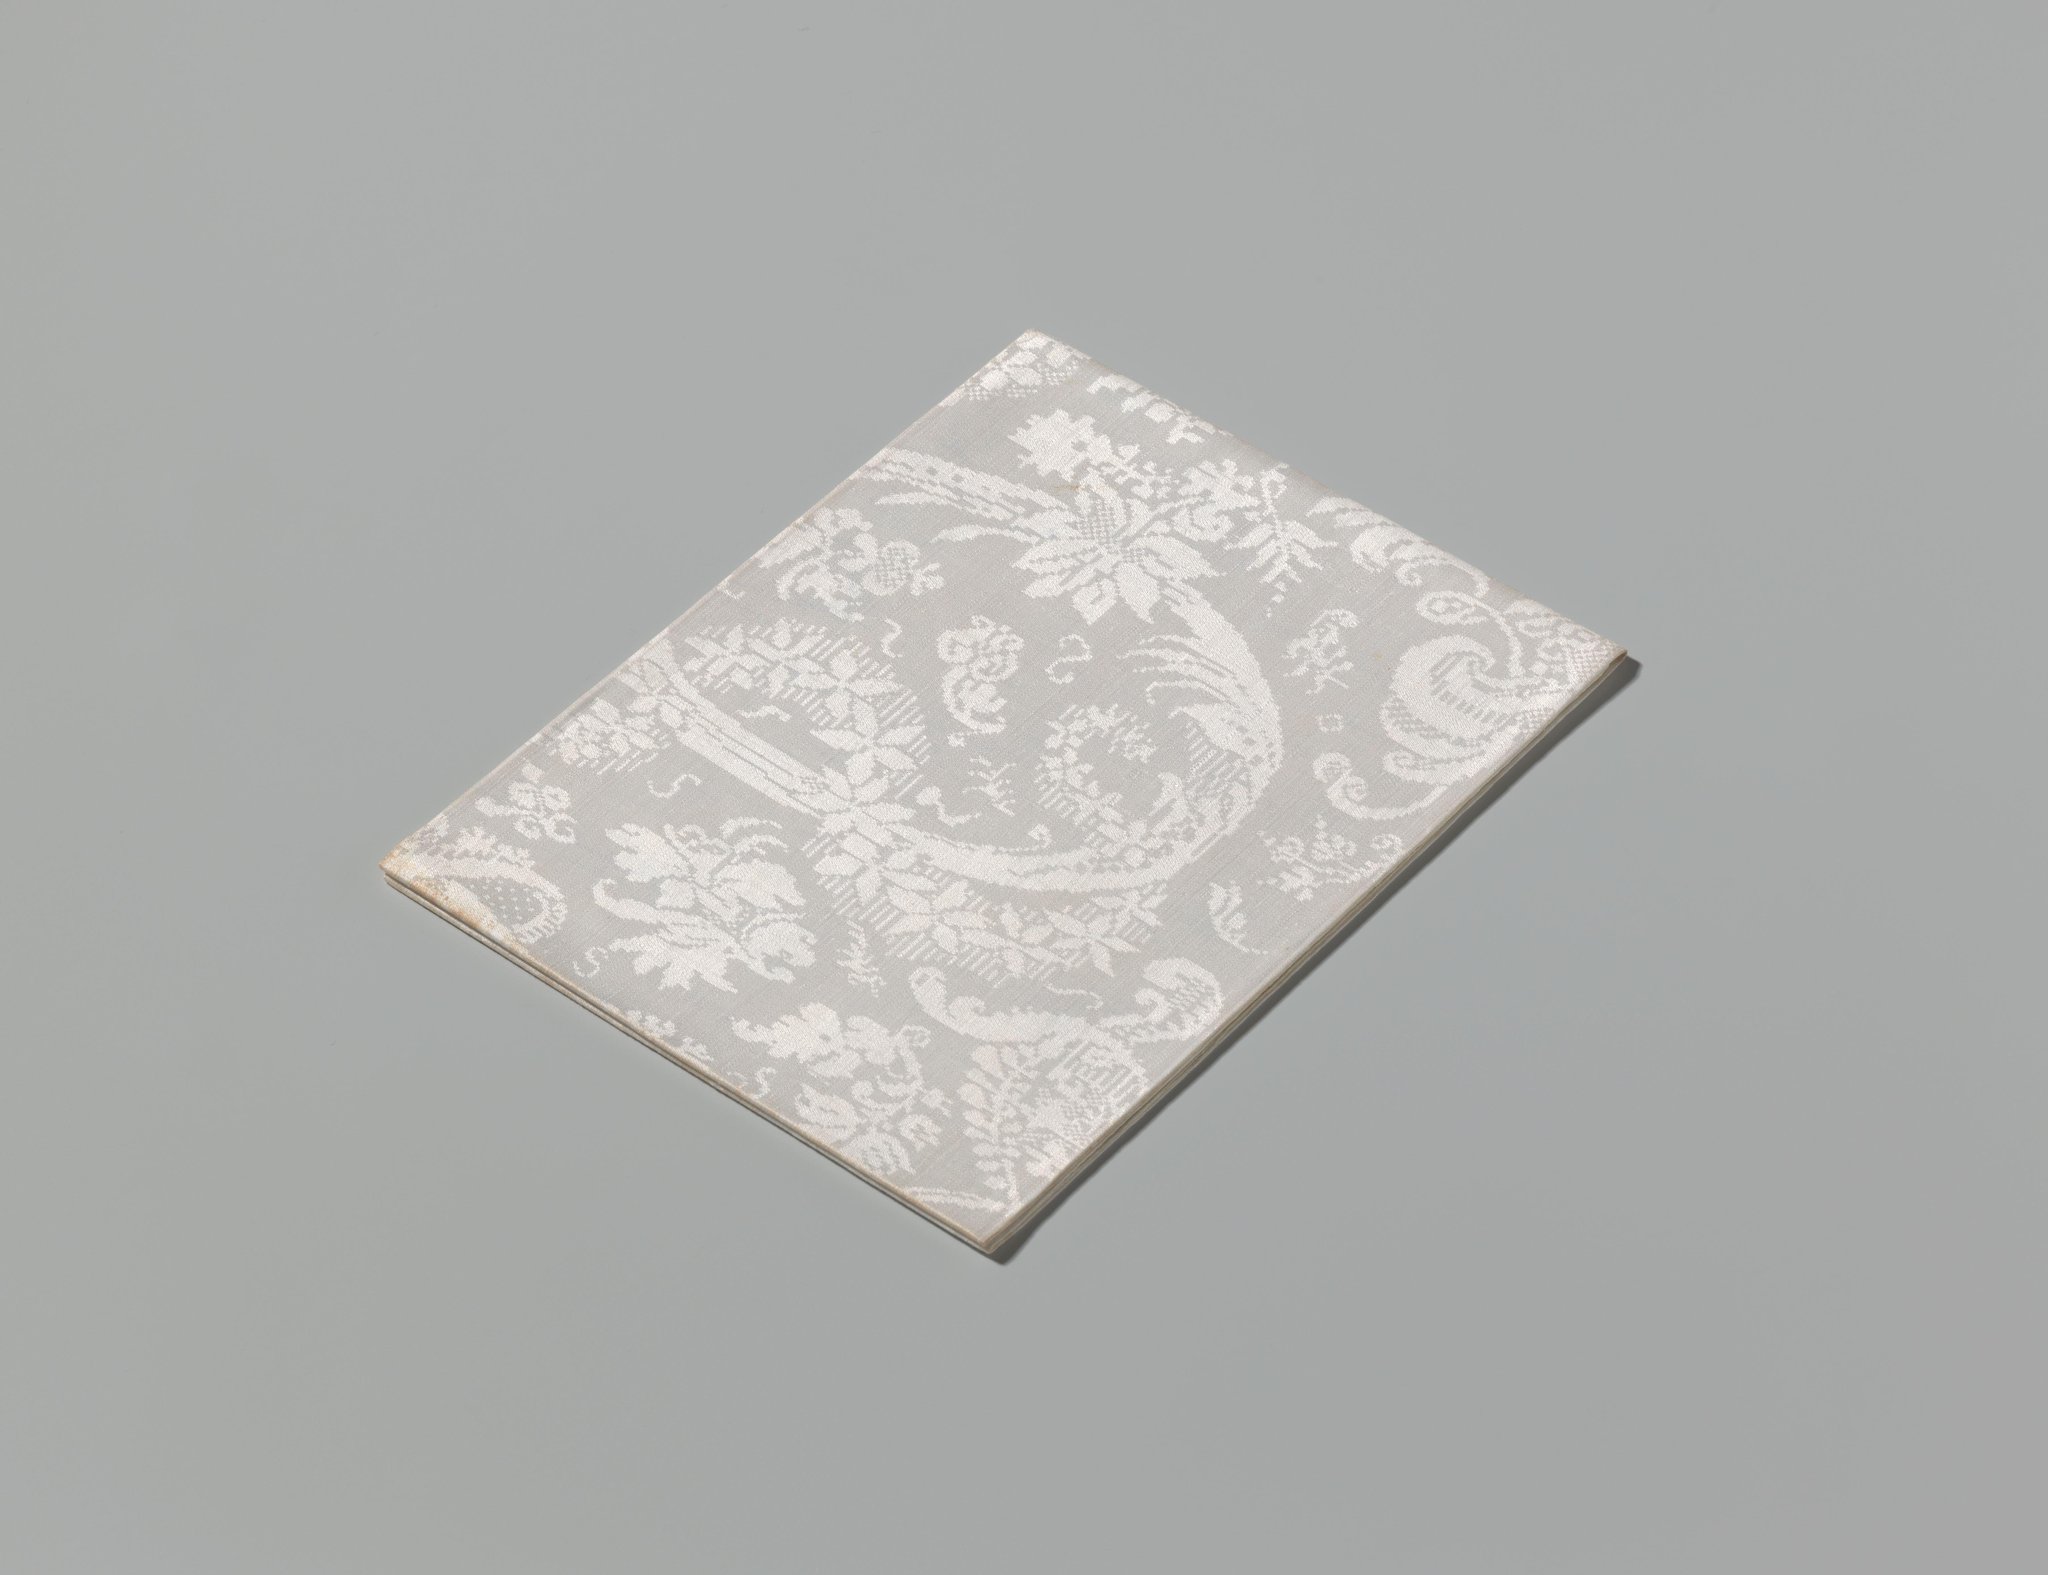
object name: napkin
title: Servet van wit linnendamast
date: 1692-1700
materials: linen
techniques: damask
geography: northern netherlands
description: Wit linnendamasten servet met patroon van voluten, merk IS 24.